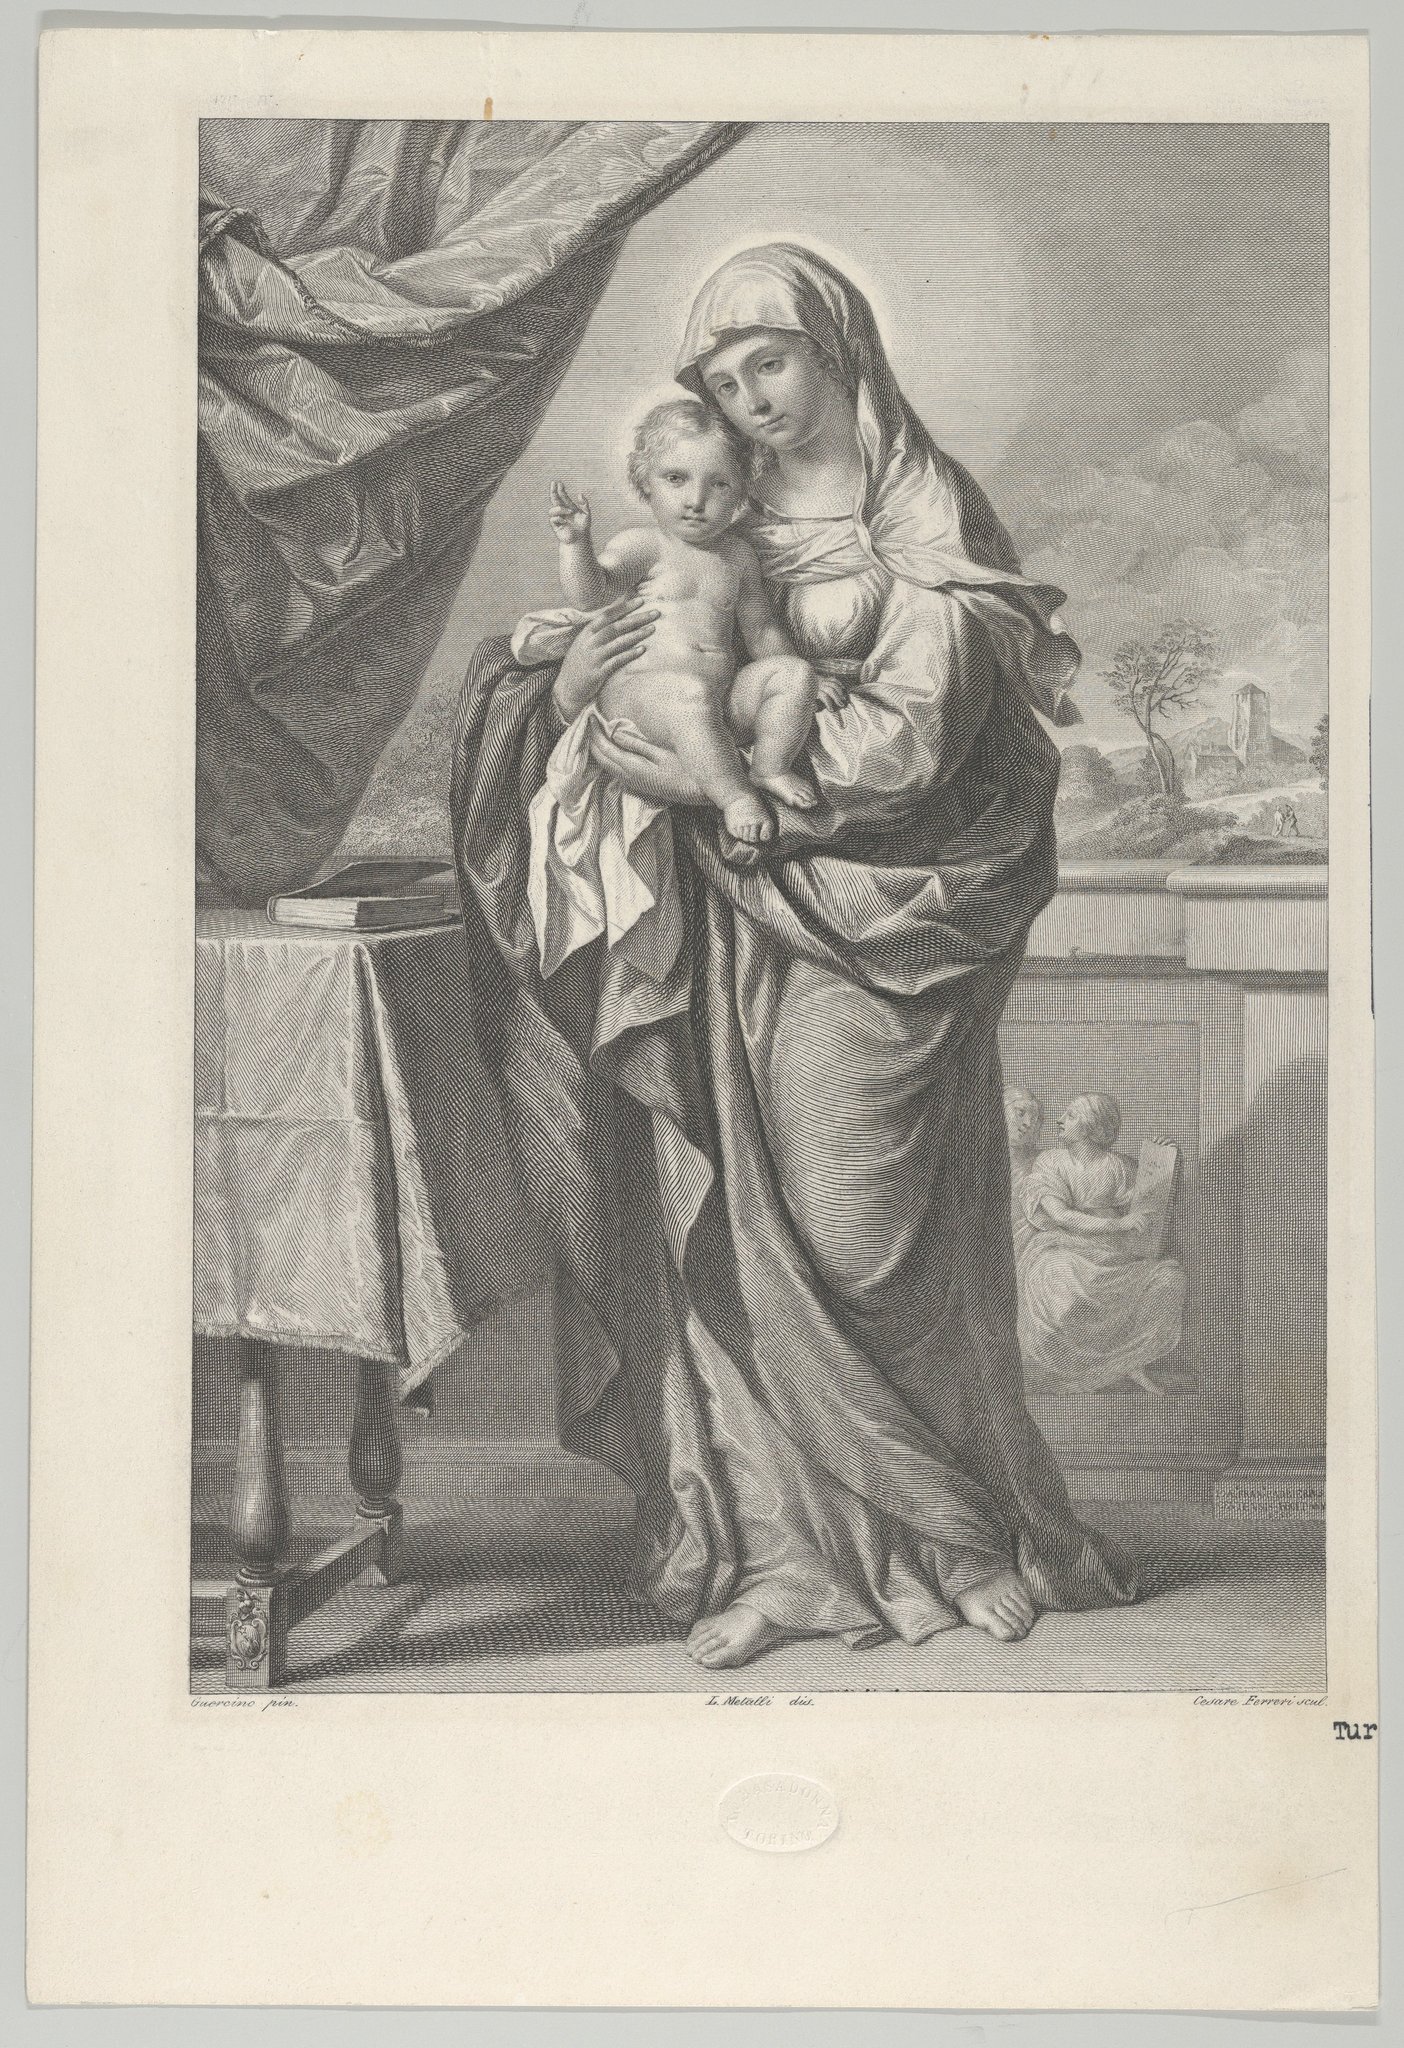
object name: print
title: Virgin and Child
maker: cesare ferreri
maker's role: artist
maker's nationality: italian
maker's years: 1802-1859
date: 1801-1900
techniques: engraving, etching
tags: madonna and child